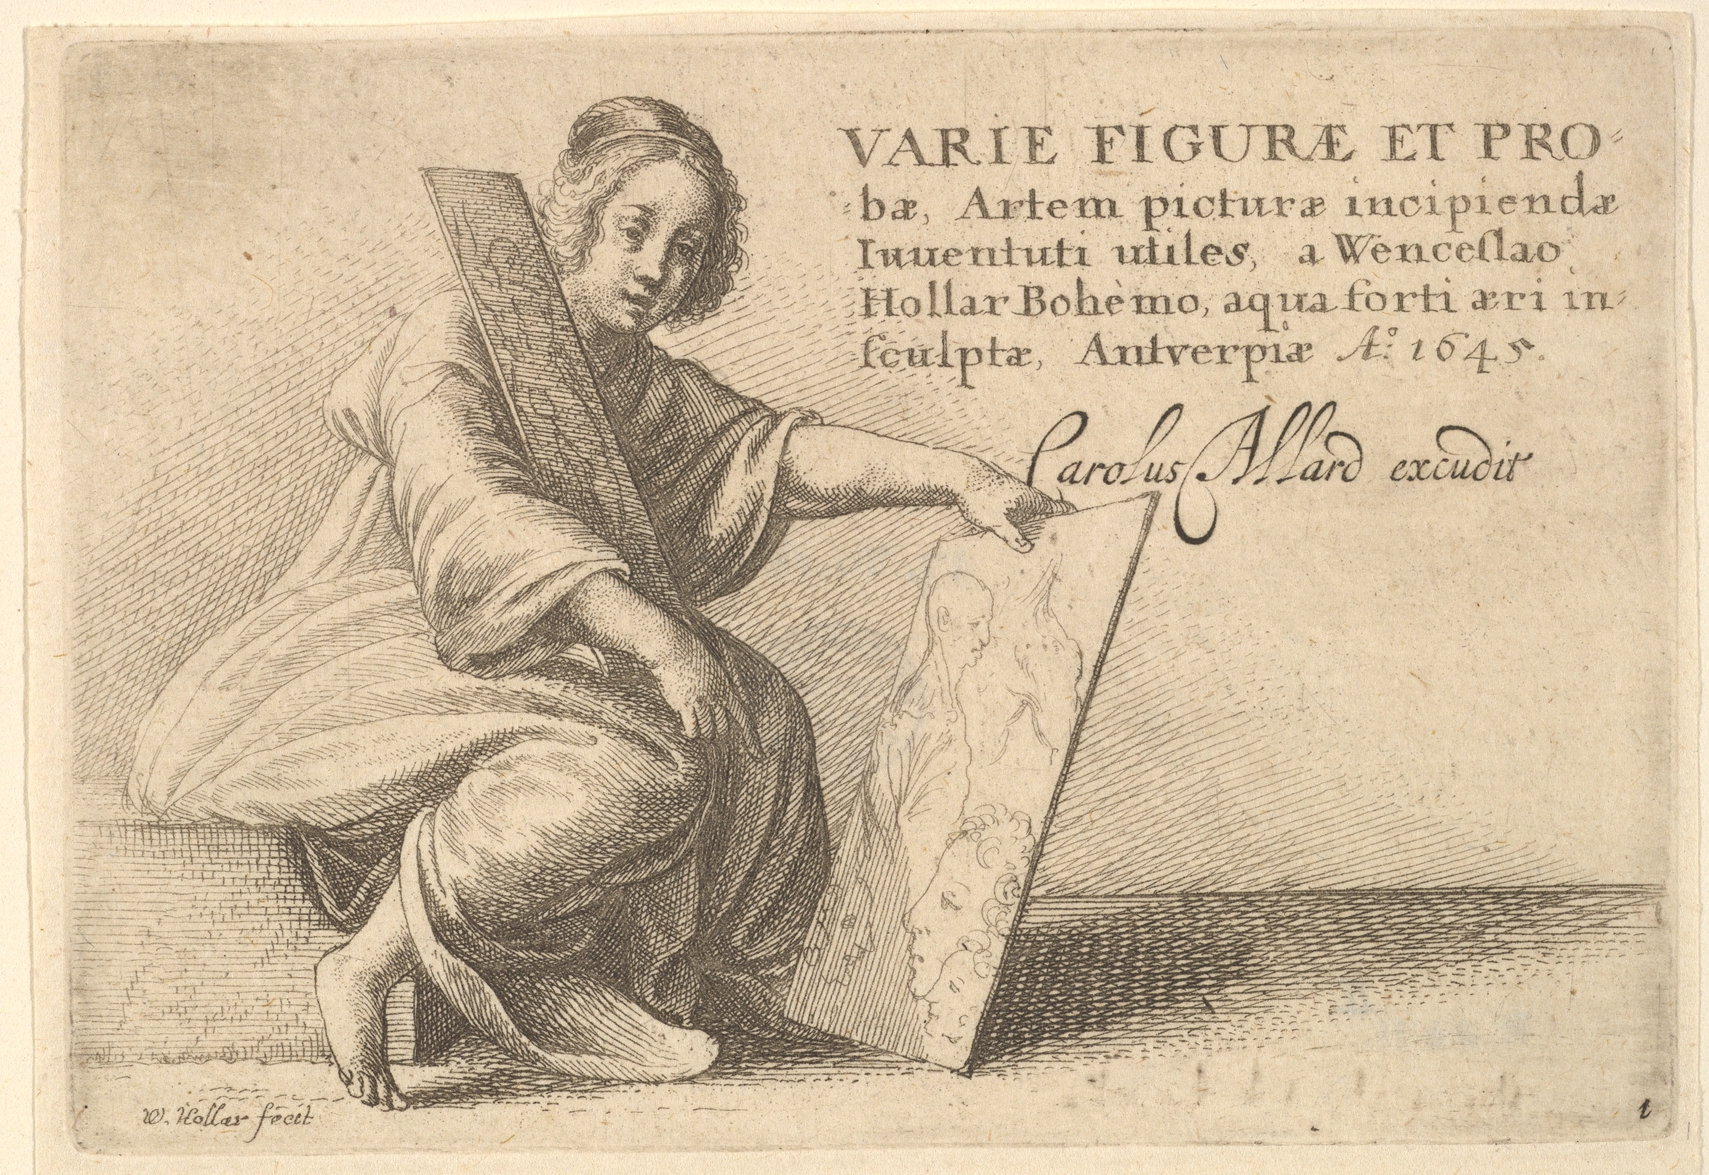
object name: print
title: Varie Figuræ et Probæ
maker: wenceslaus hollar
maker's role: artist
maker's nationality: bohemian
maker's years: 1607-1677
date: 1645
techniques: etching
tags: women